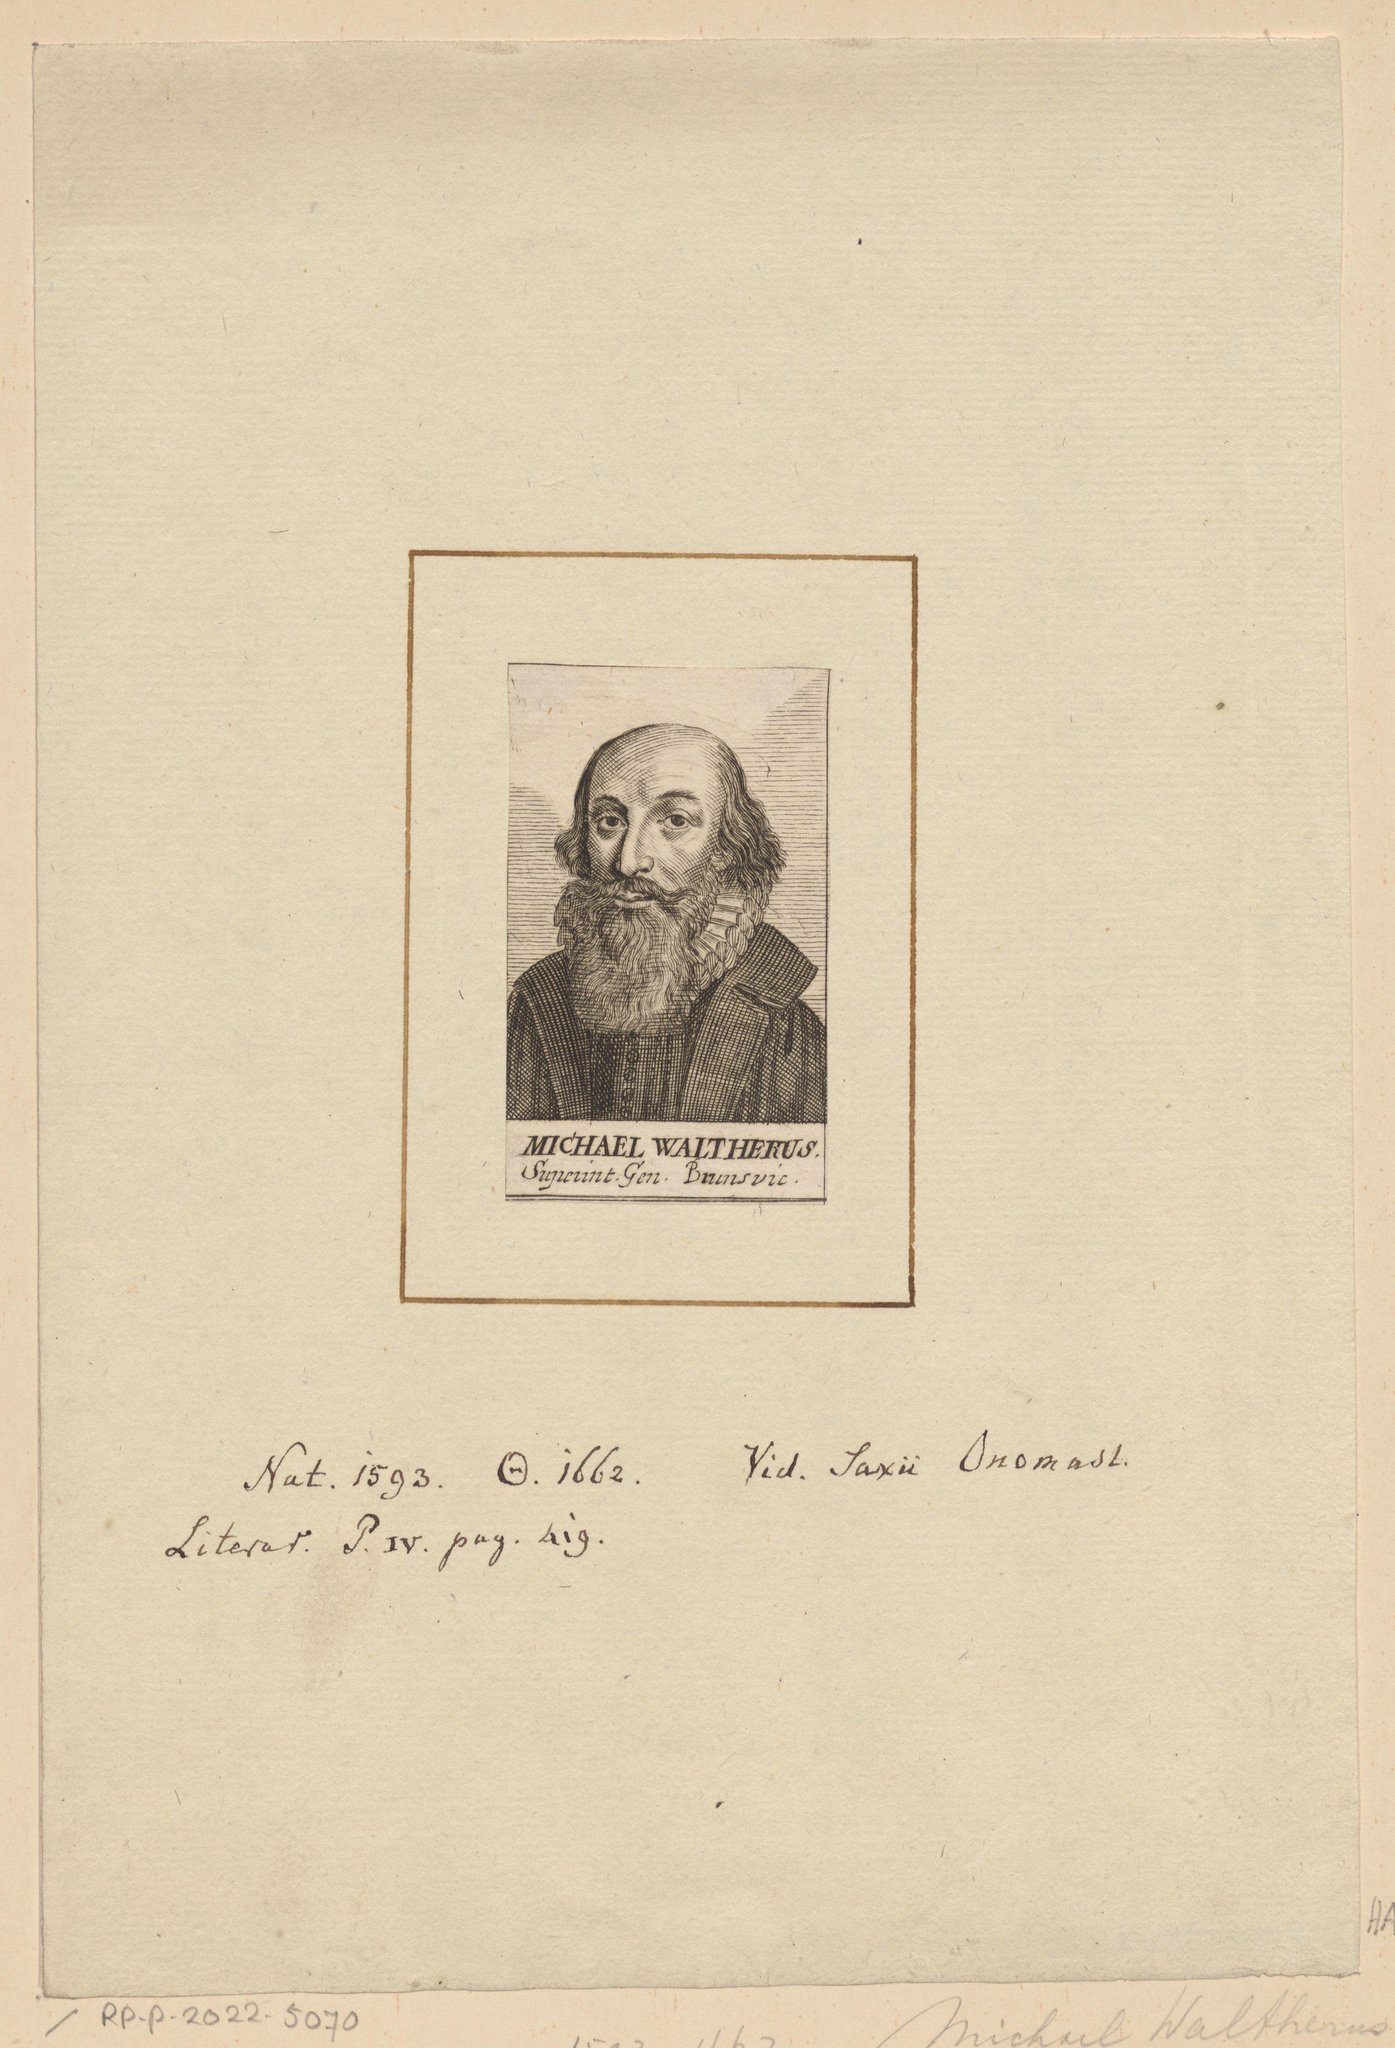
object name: print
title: Portret van Michael Walther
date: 1688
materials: paper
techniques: engraving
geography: nuremberg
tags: theologian, historical persons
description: Prent uit: Freher, Paul. Theatrum virorum eruditione clarorum. Neurenberg: Johann Hoffmann, 1688.